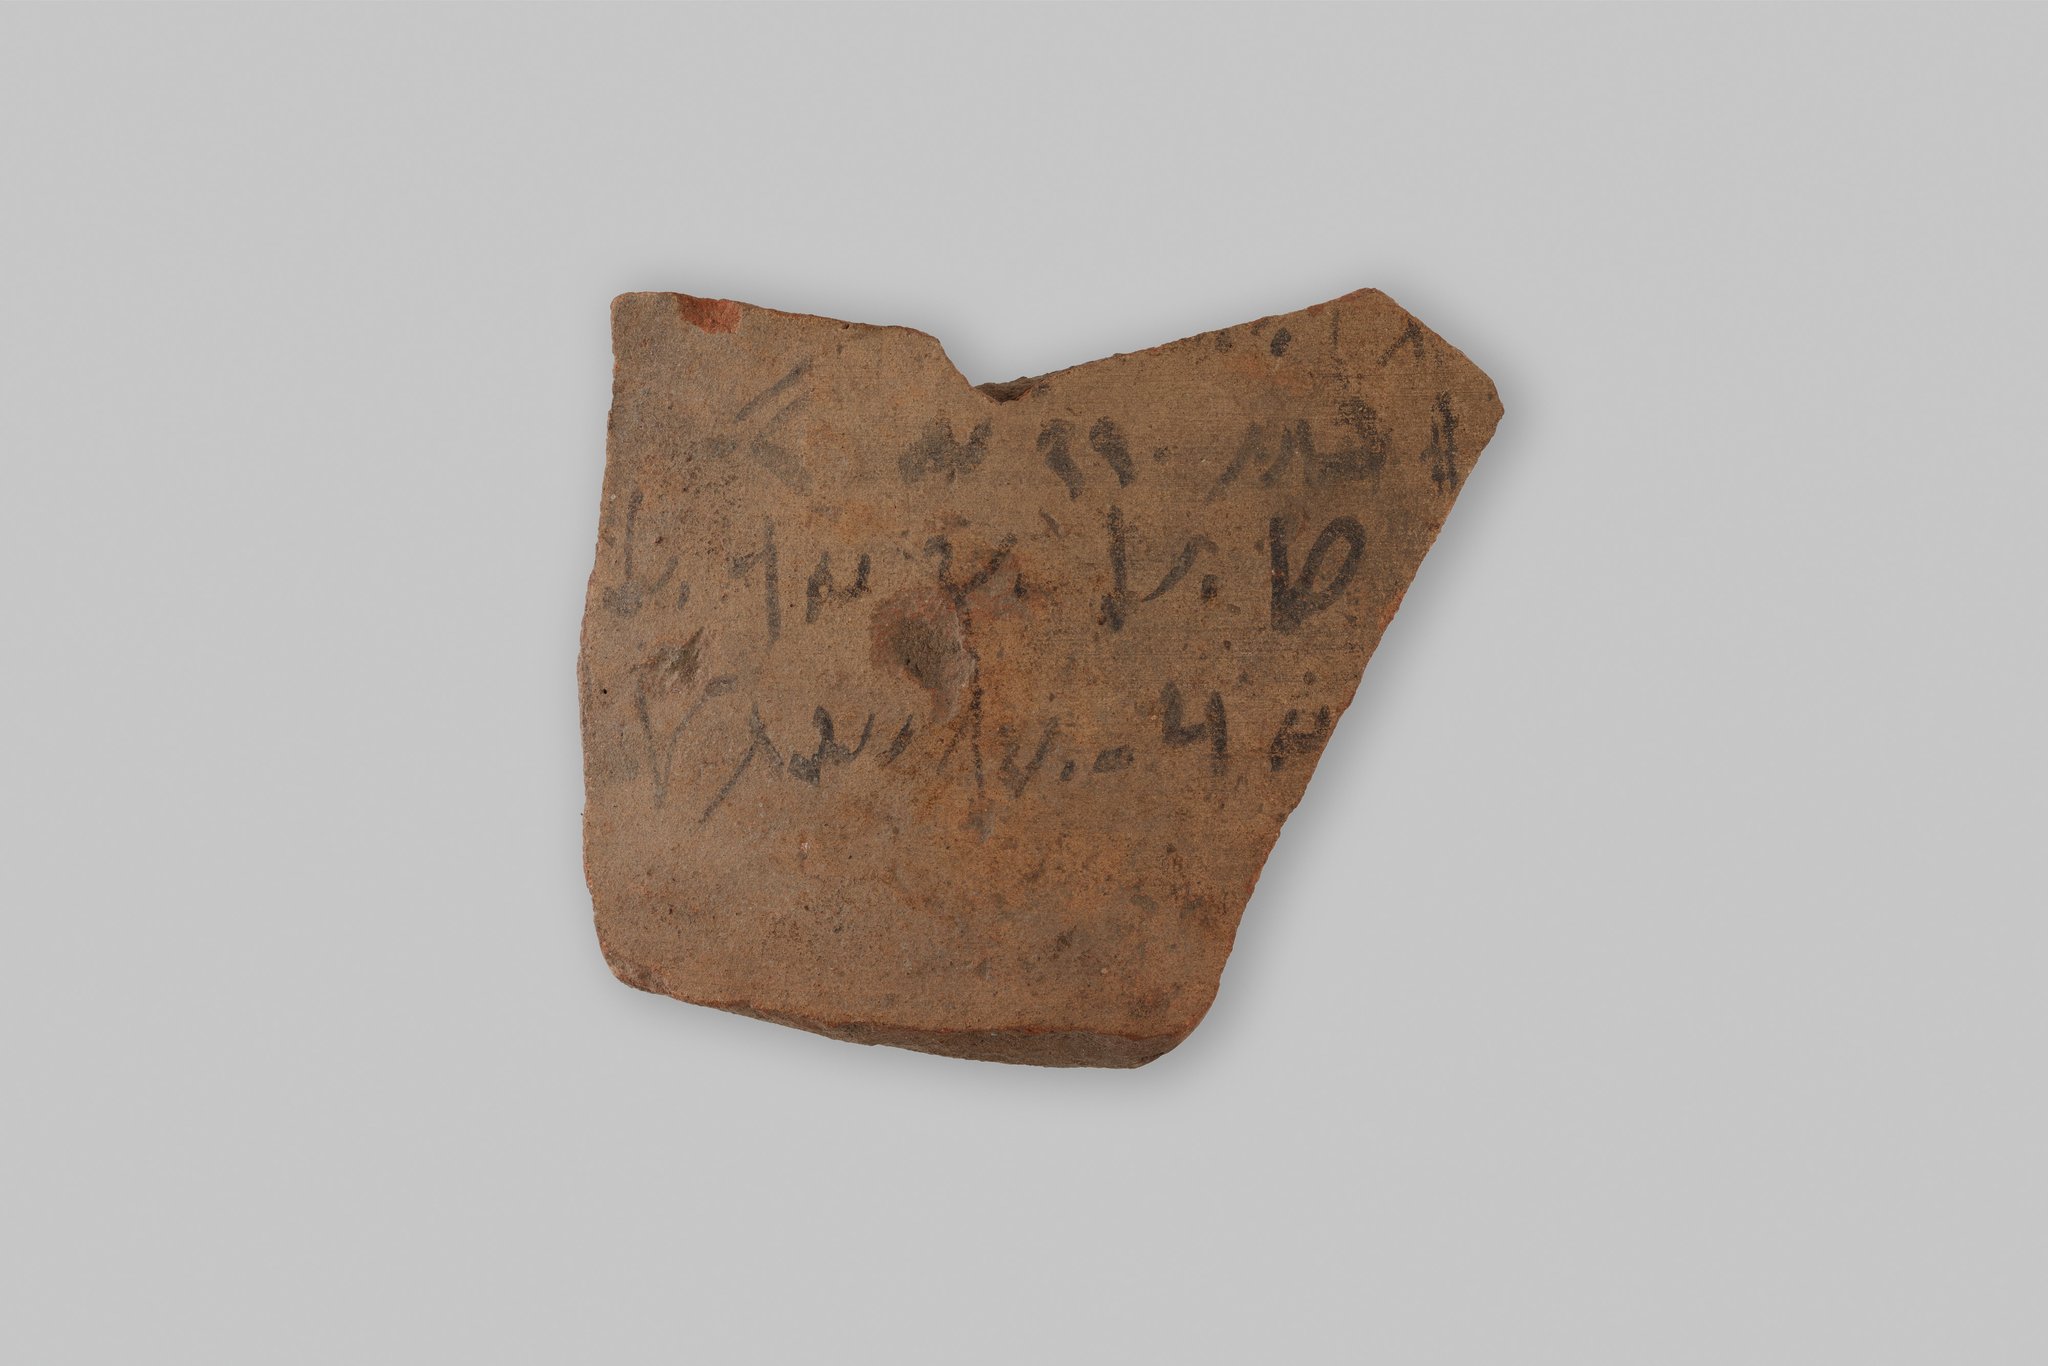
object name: ostracon, demotic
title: Ostracon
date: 600-30 BCE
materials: ink, pottery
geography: egypt